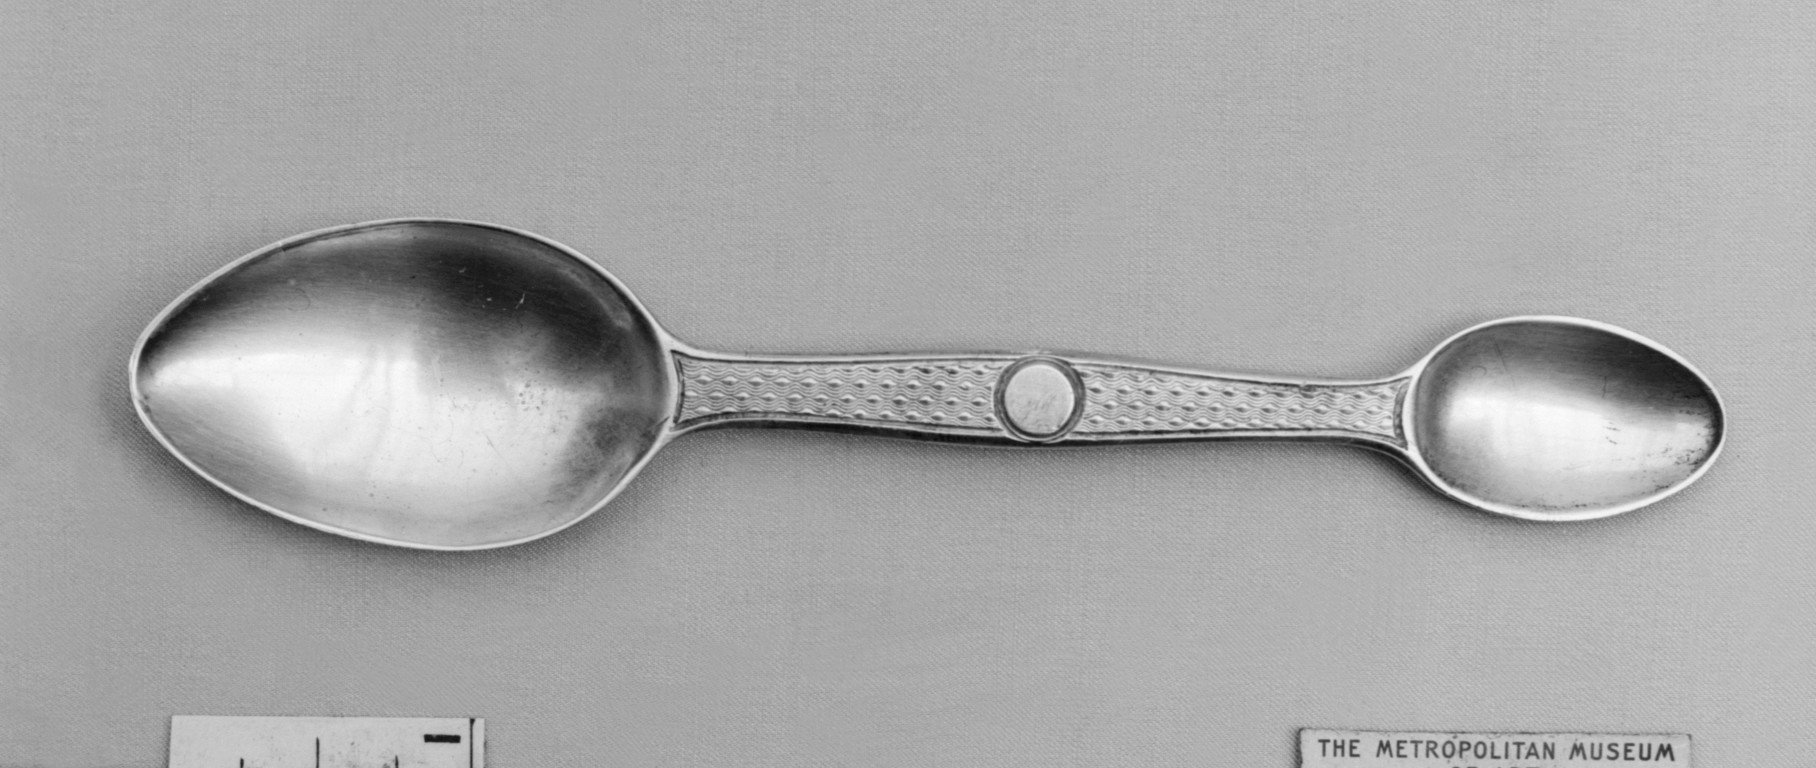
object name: medicine spoon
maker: t. j., london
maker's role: maker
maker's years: 1858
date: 1858-1859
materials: silver